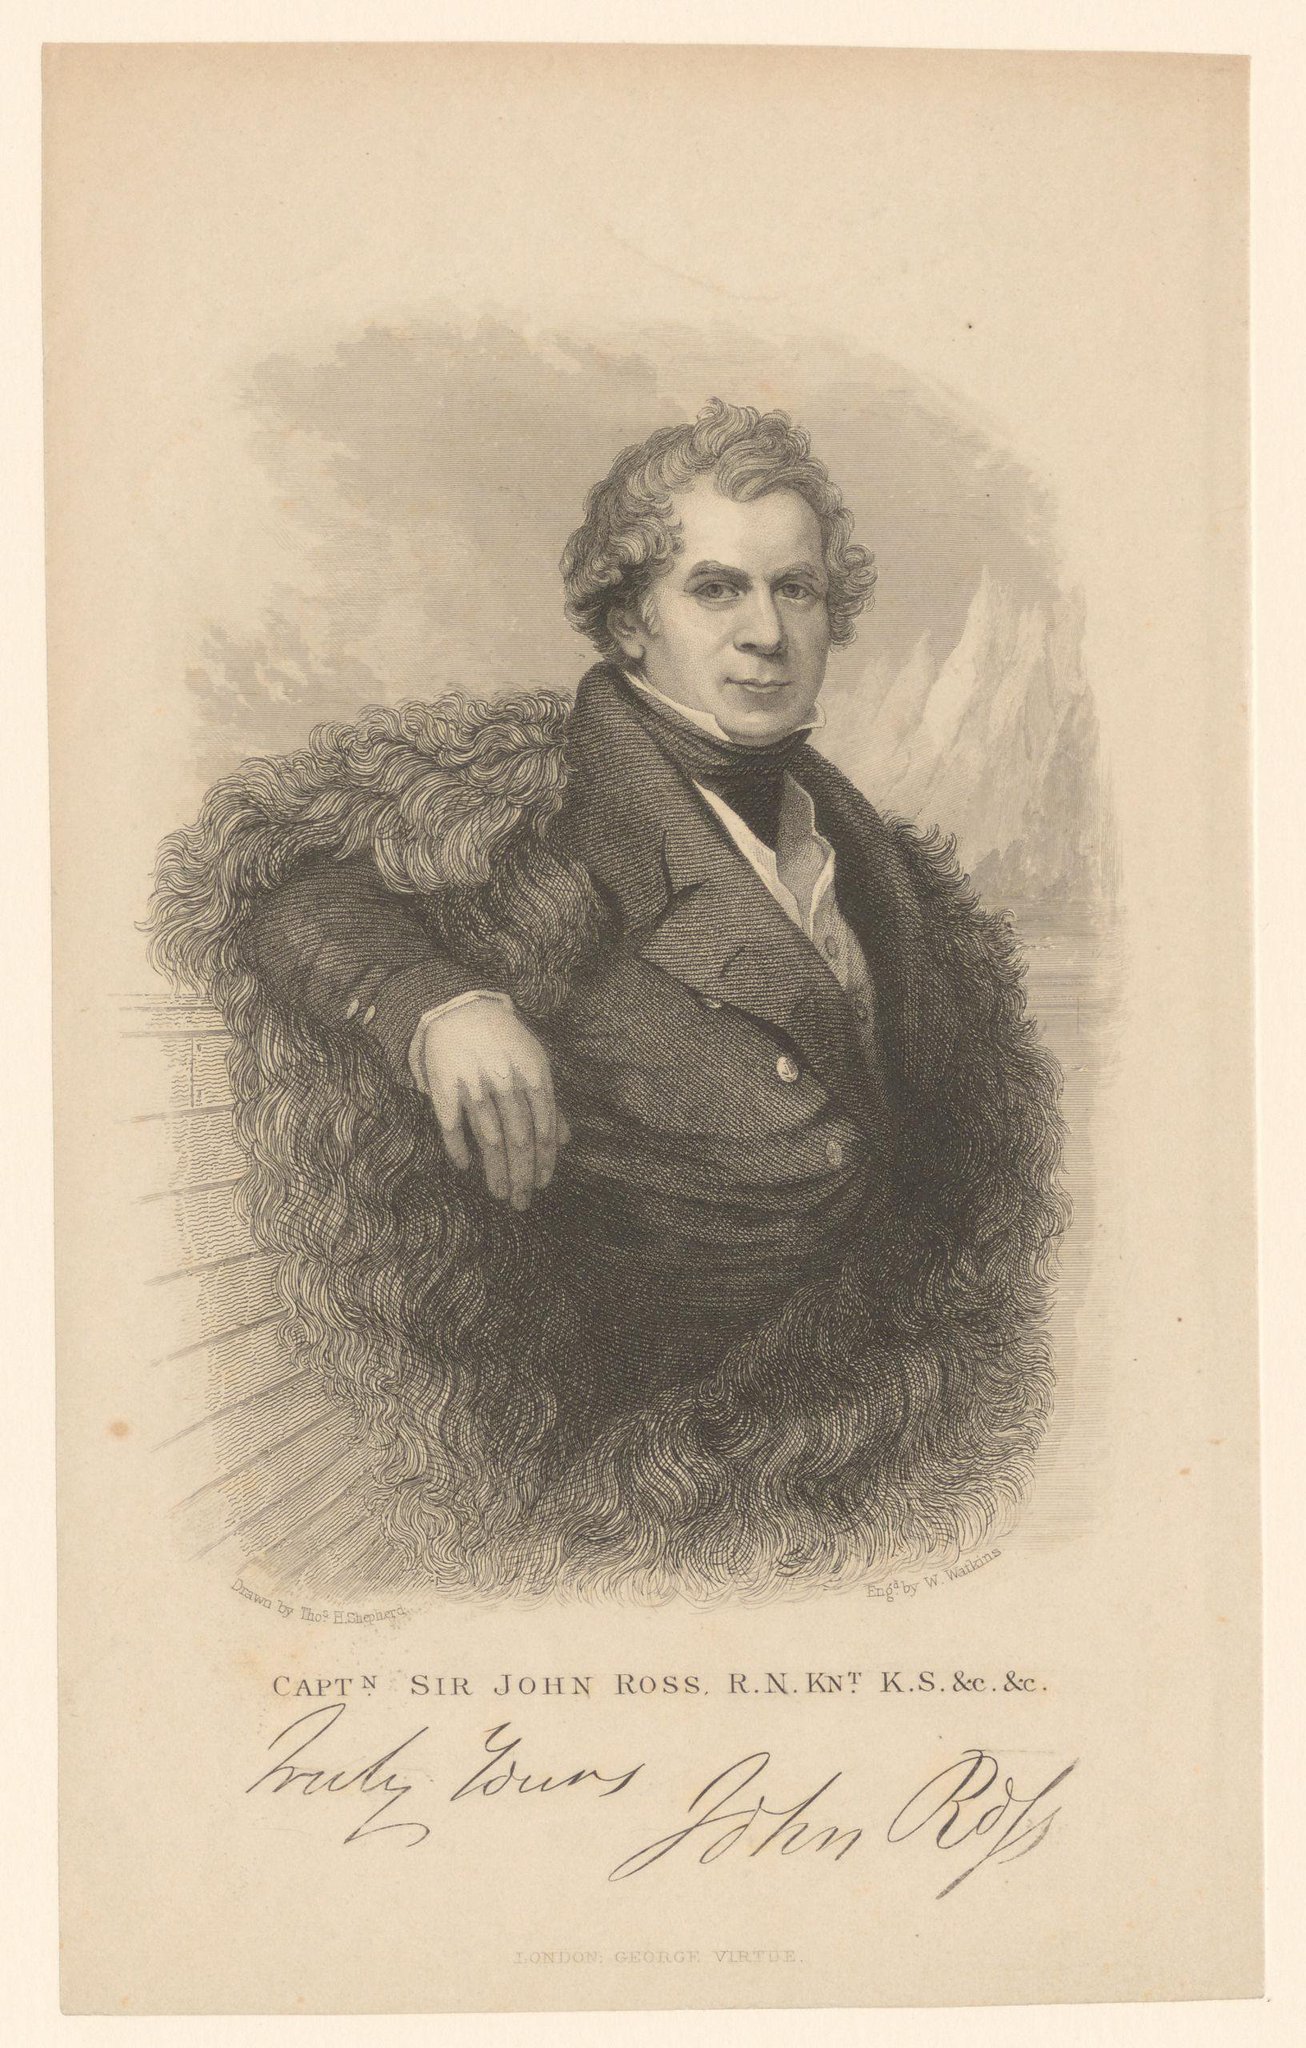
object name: print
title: Portret van John Ross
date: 1823-1831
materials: paper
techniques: engraving, etching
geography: london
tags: draughtsman, john ross, publishing, publisher (+ portrait of scholar, scientist), historical persons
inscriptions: collector's mark: Lugt 2228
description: Een facsimile signatuur in de ondermarge.